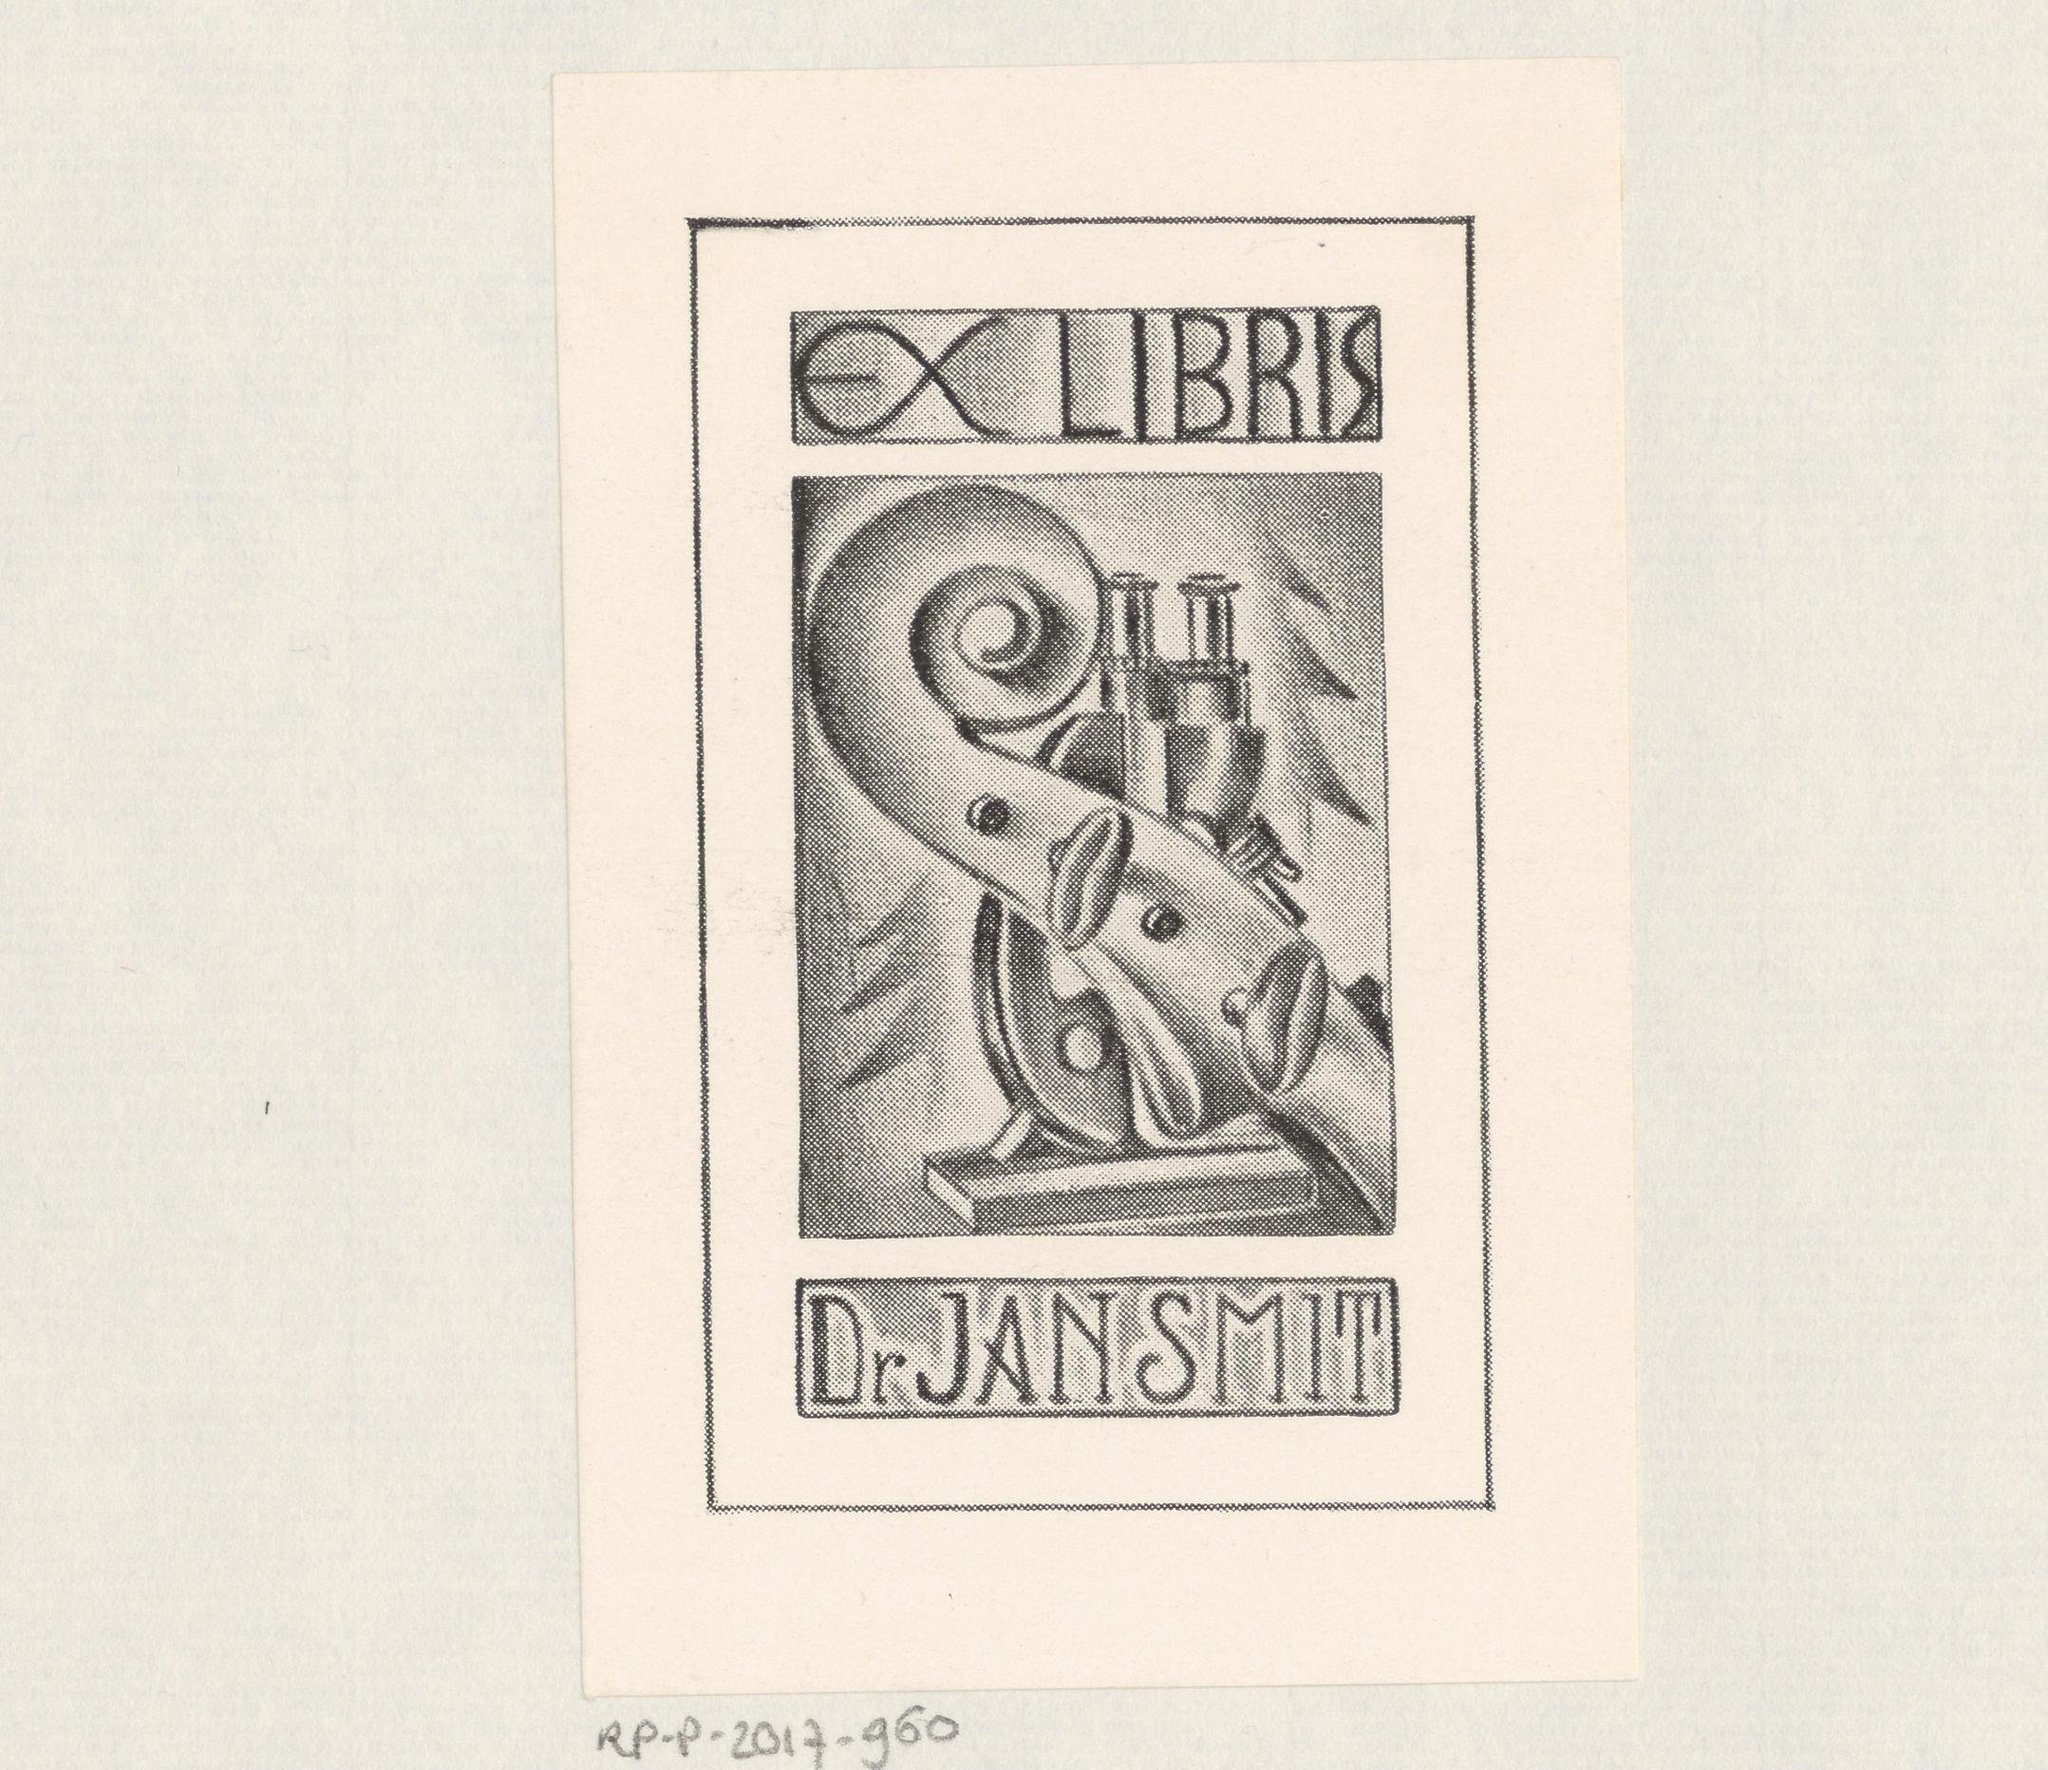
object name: bookplate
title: Ex libris van Jan Smit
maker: Anonymous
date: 1900-1999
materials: paper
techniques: autotype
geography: netherlands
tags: violin, fiddle, microscope